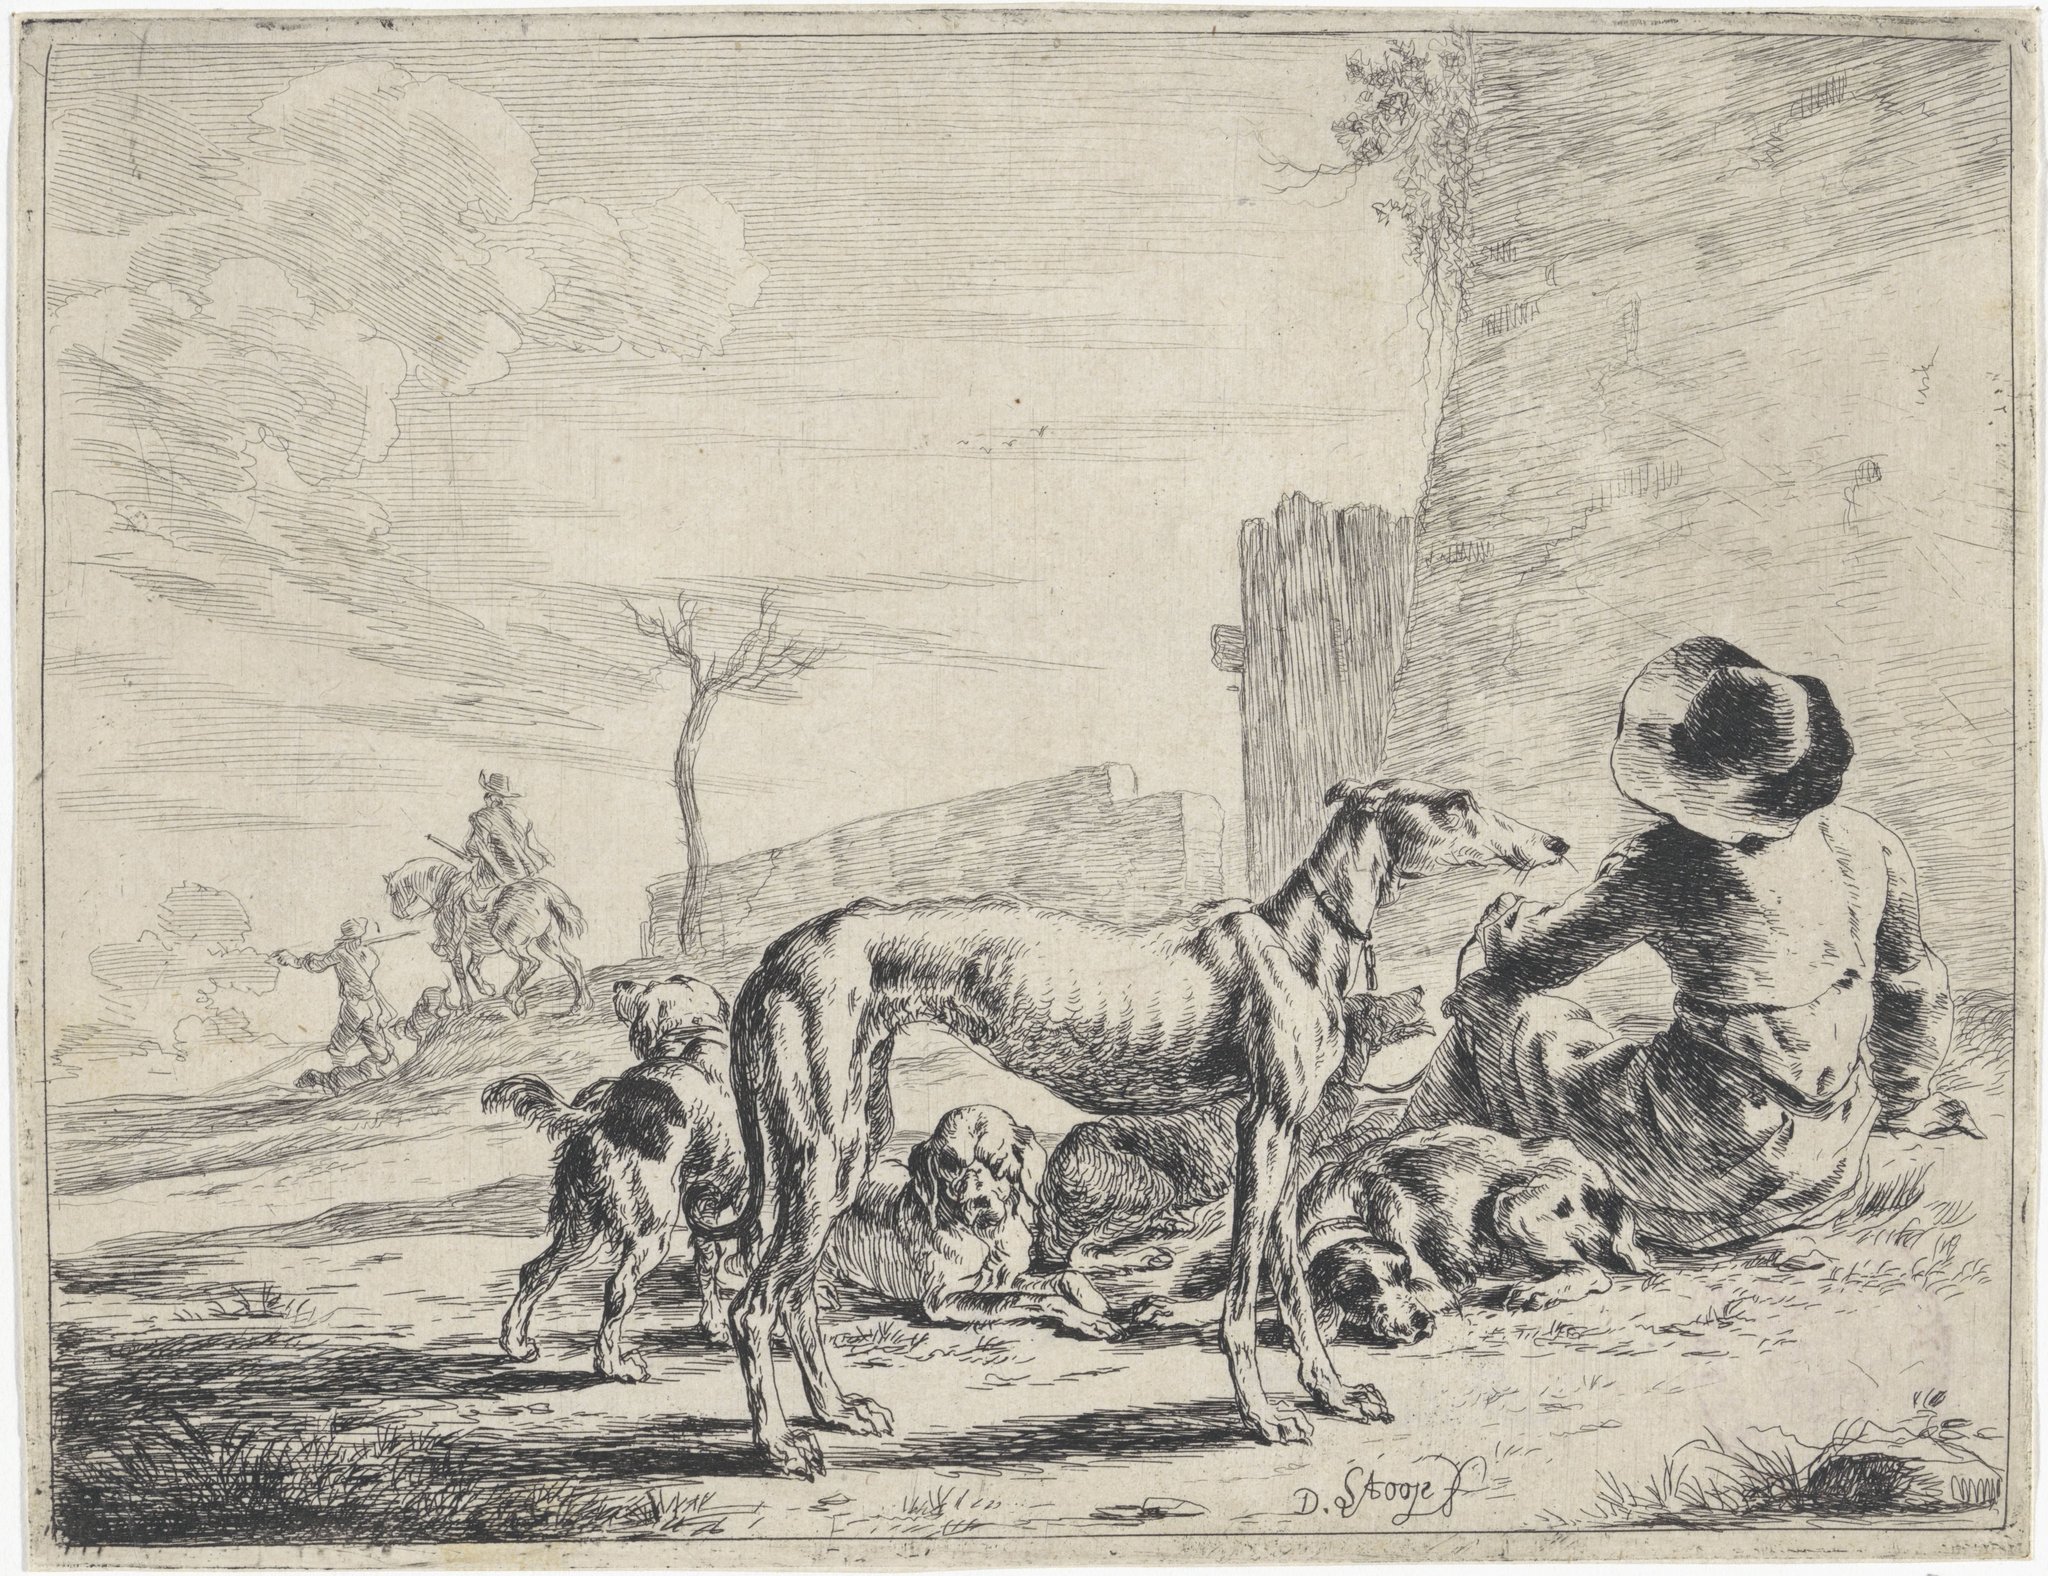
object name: print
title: Paarden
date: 1651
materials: paper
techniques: etching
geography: utrecht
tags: horse, sitting on the ground, dog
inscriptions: collector's mark: Lugt 240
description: Een man, op de rug gezien, zit op de grond te midden van vijf honden. Links een ruiter en een man te voet met honden.